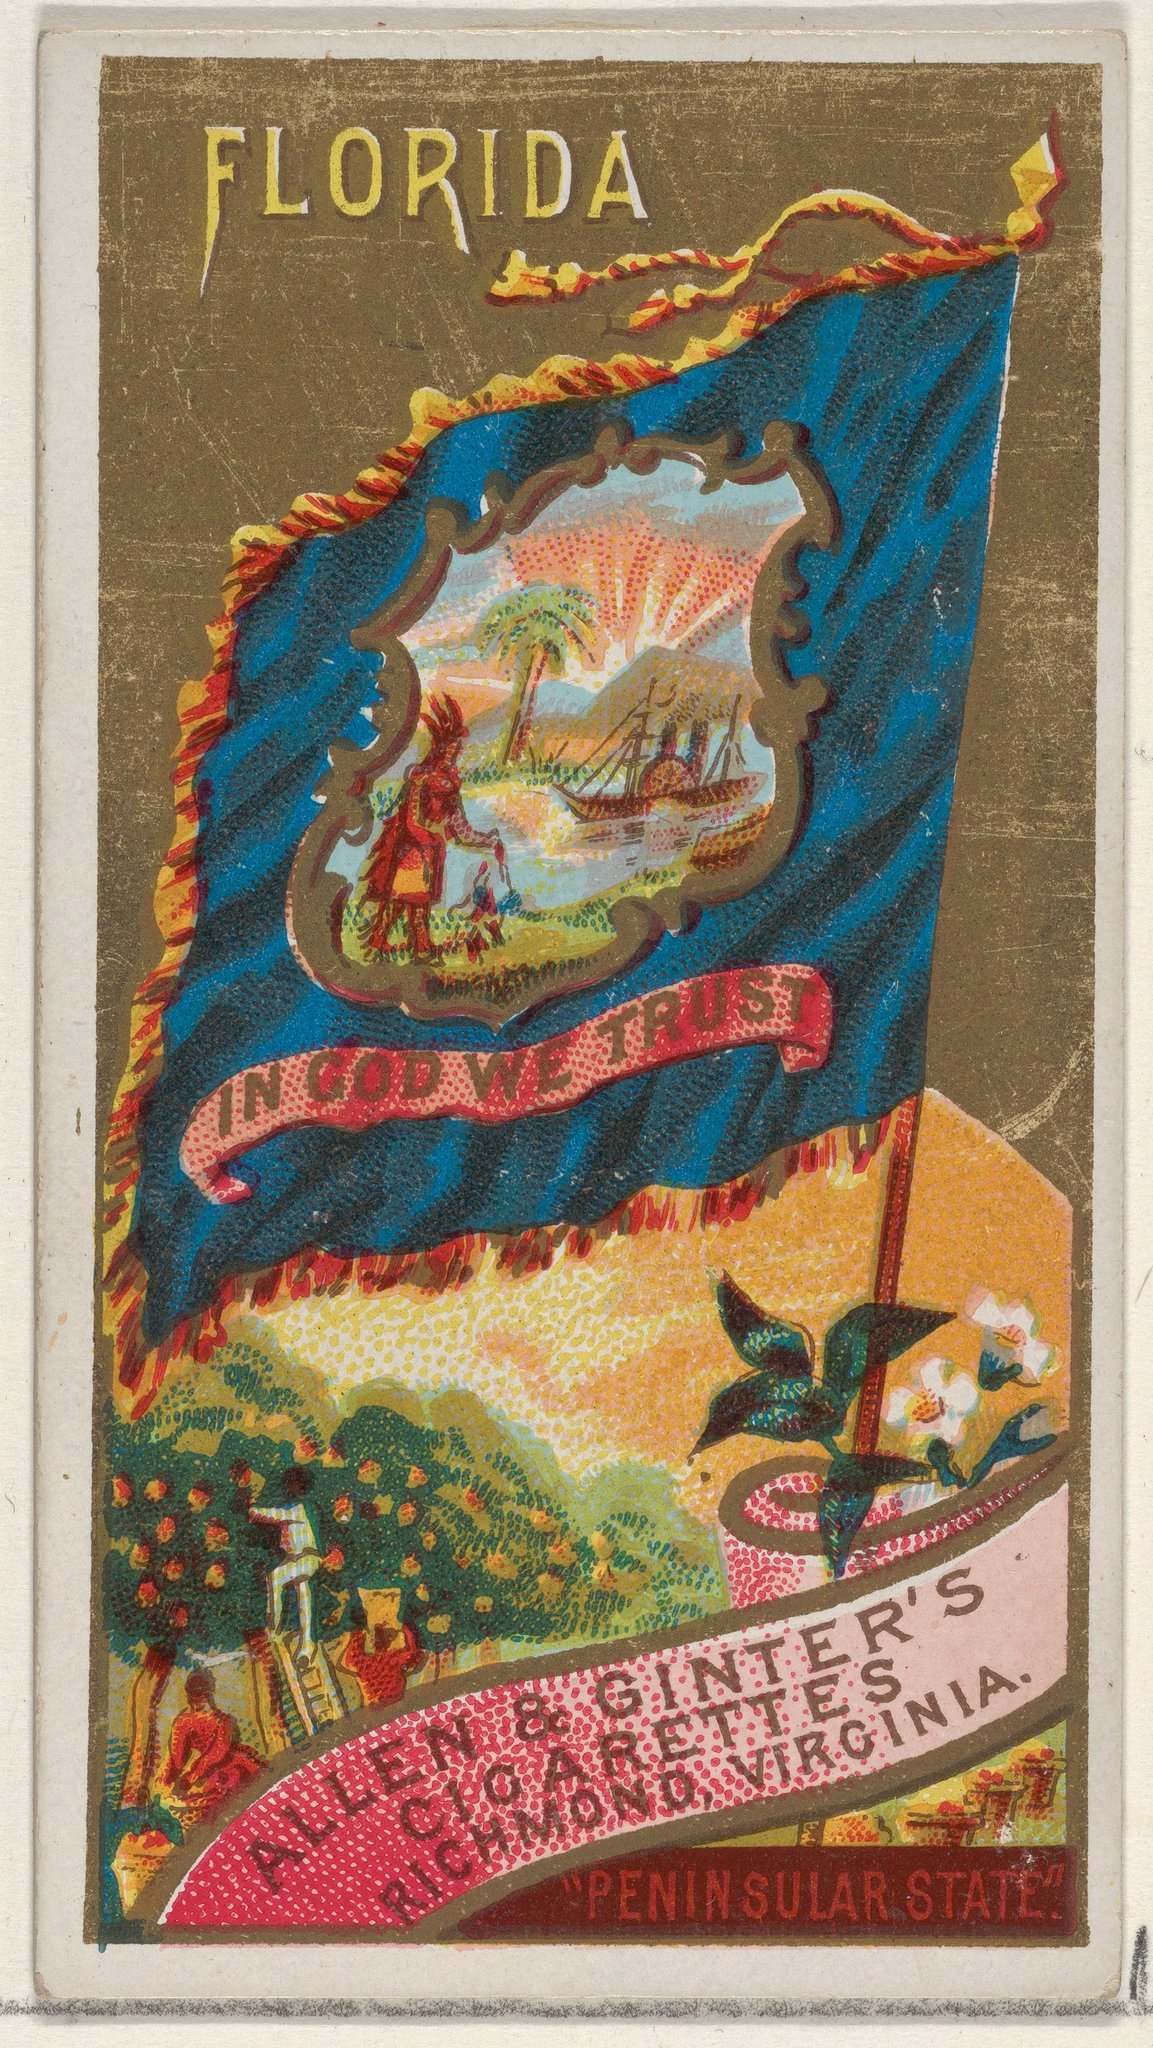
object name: print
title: Florida, from Flags of the States and Territories (N11) for Allen & Ginter Cigarettes Brands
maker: allen & ginter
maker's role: publisher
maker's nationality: american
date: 1888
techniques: color lithograph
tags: flags